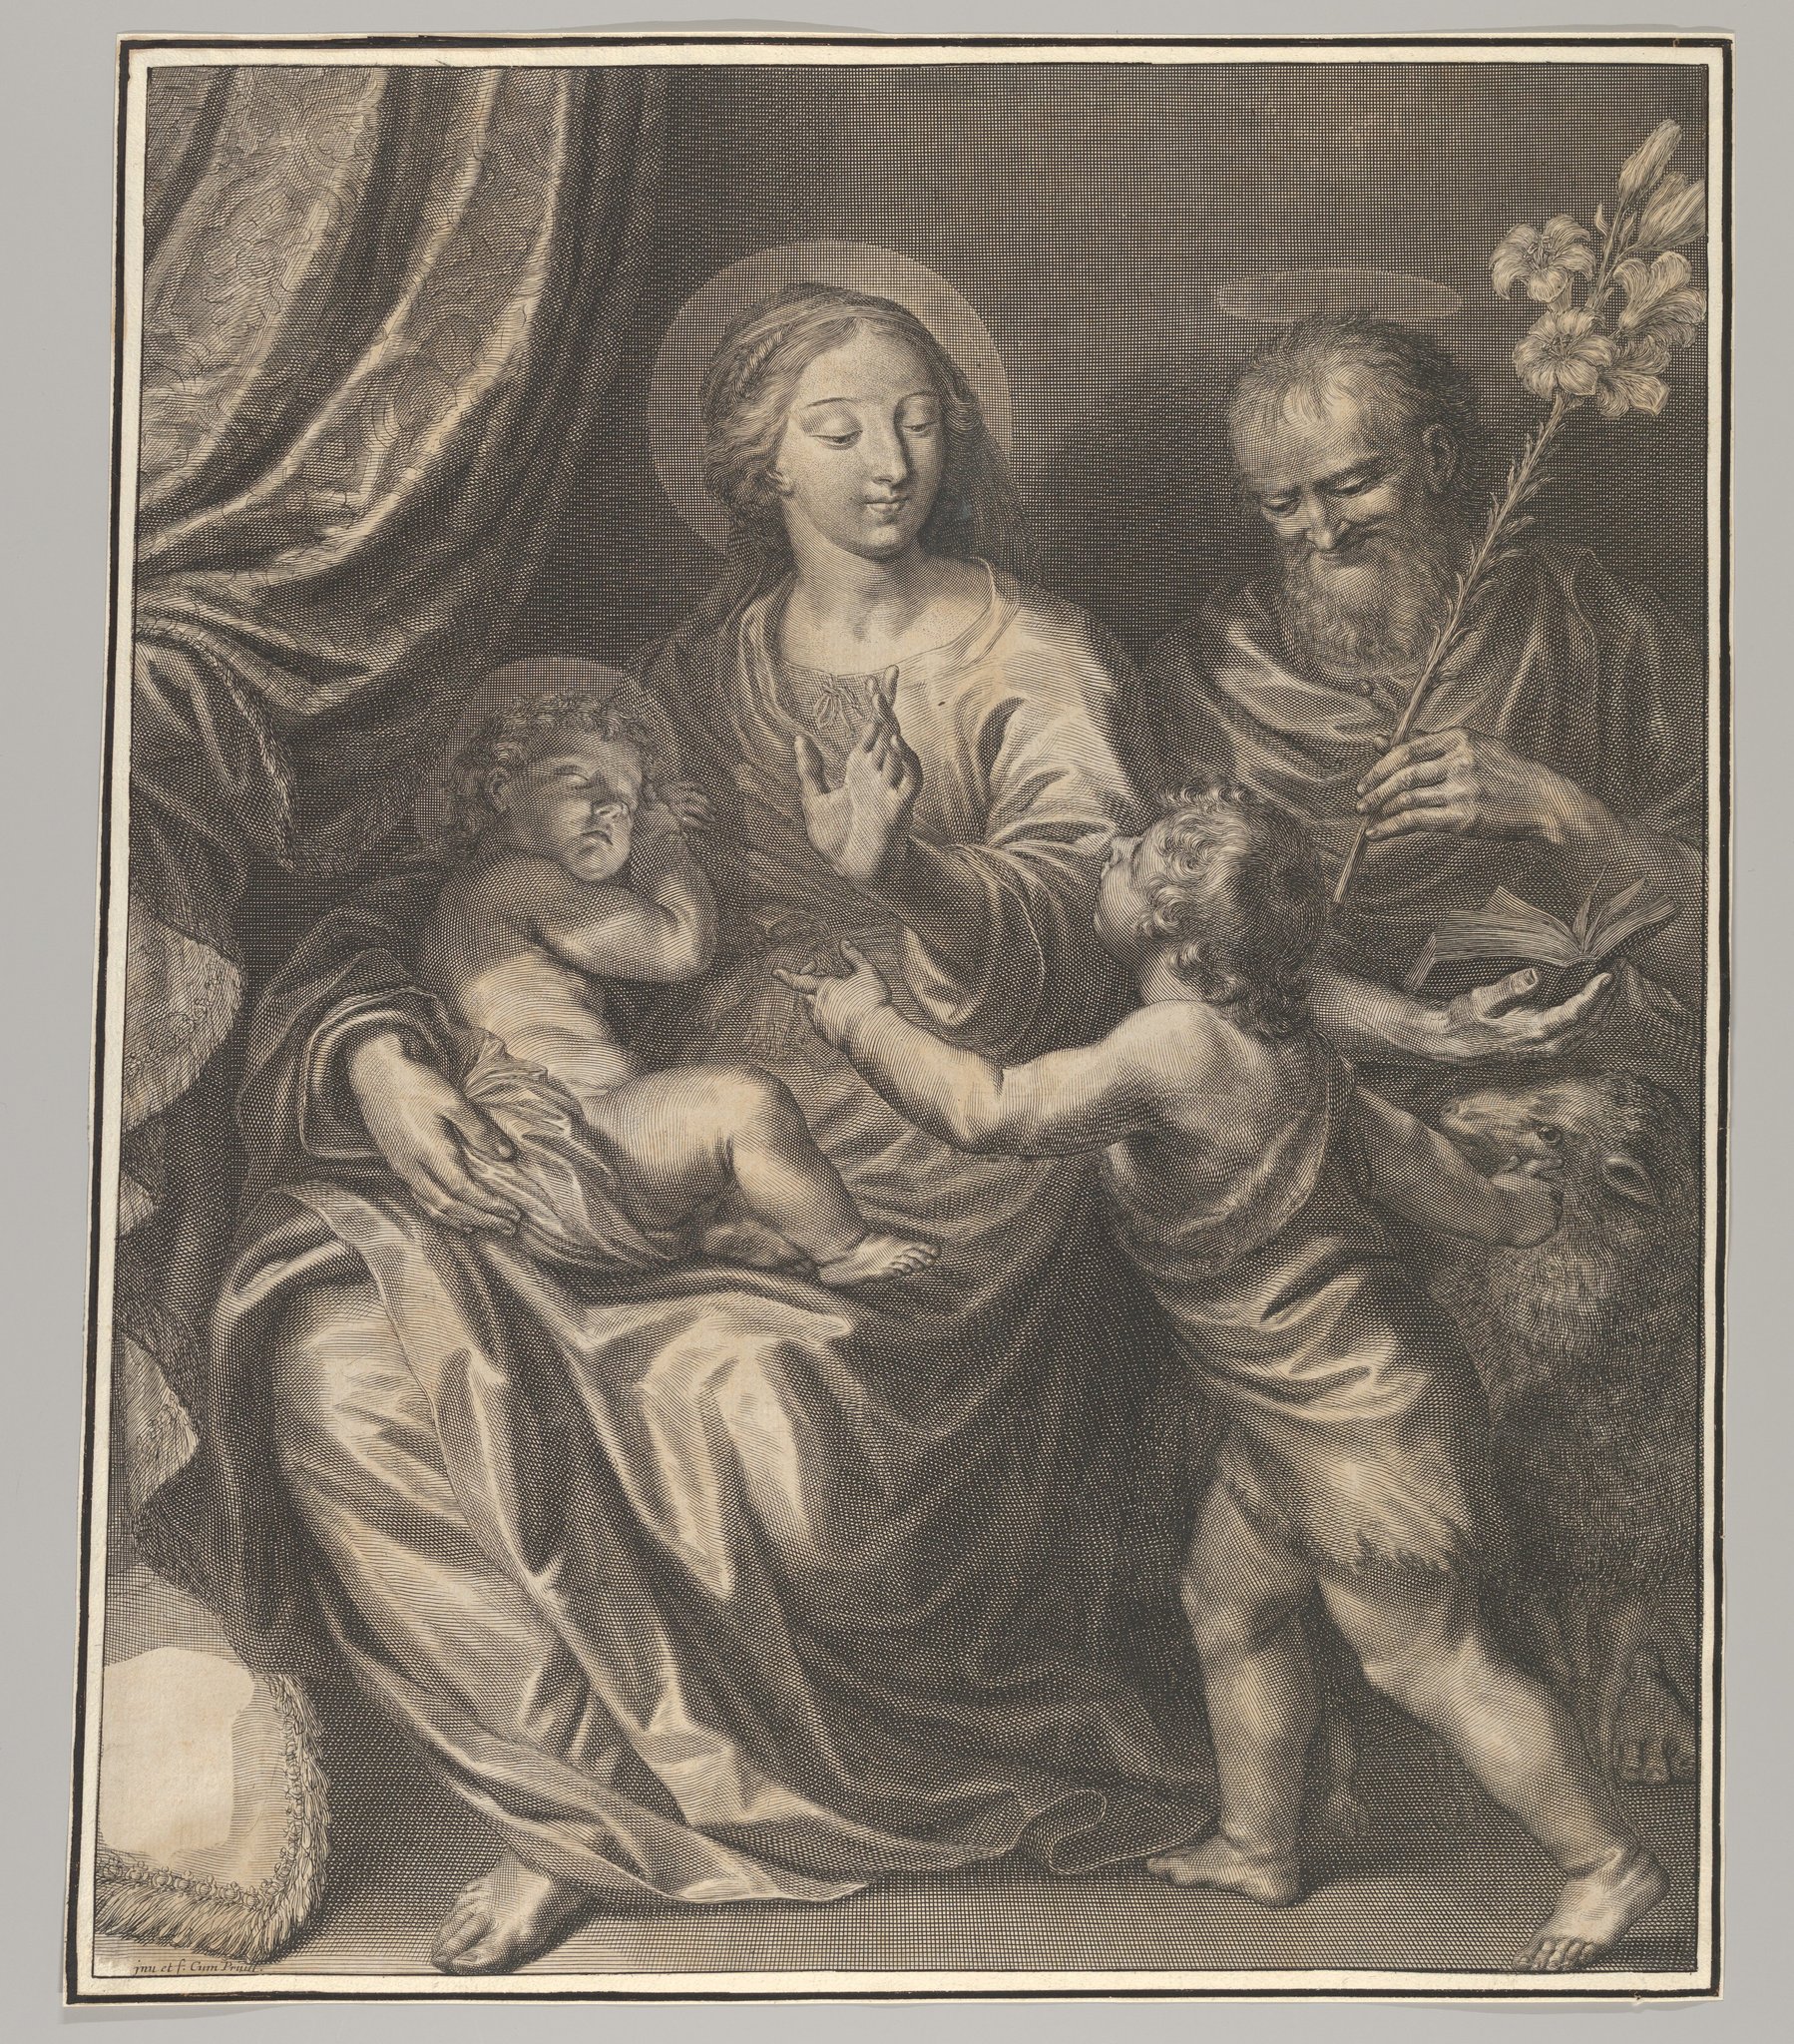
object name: print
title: Holy Family with Young St. John the Baptist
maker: grégoire huret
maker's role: artist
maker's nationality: french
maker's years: 1606-1670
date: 1601-1700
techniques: engraving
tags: animals,angels,holy family,madonna and child,saint john the baptist